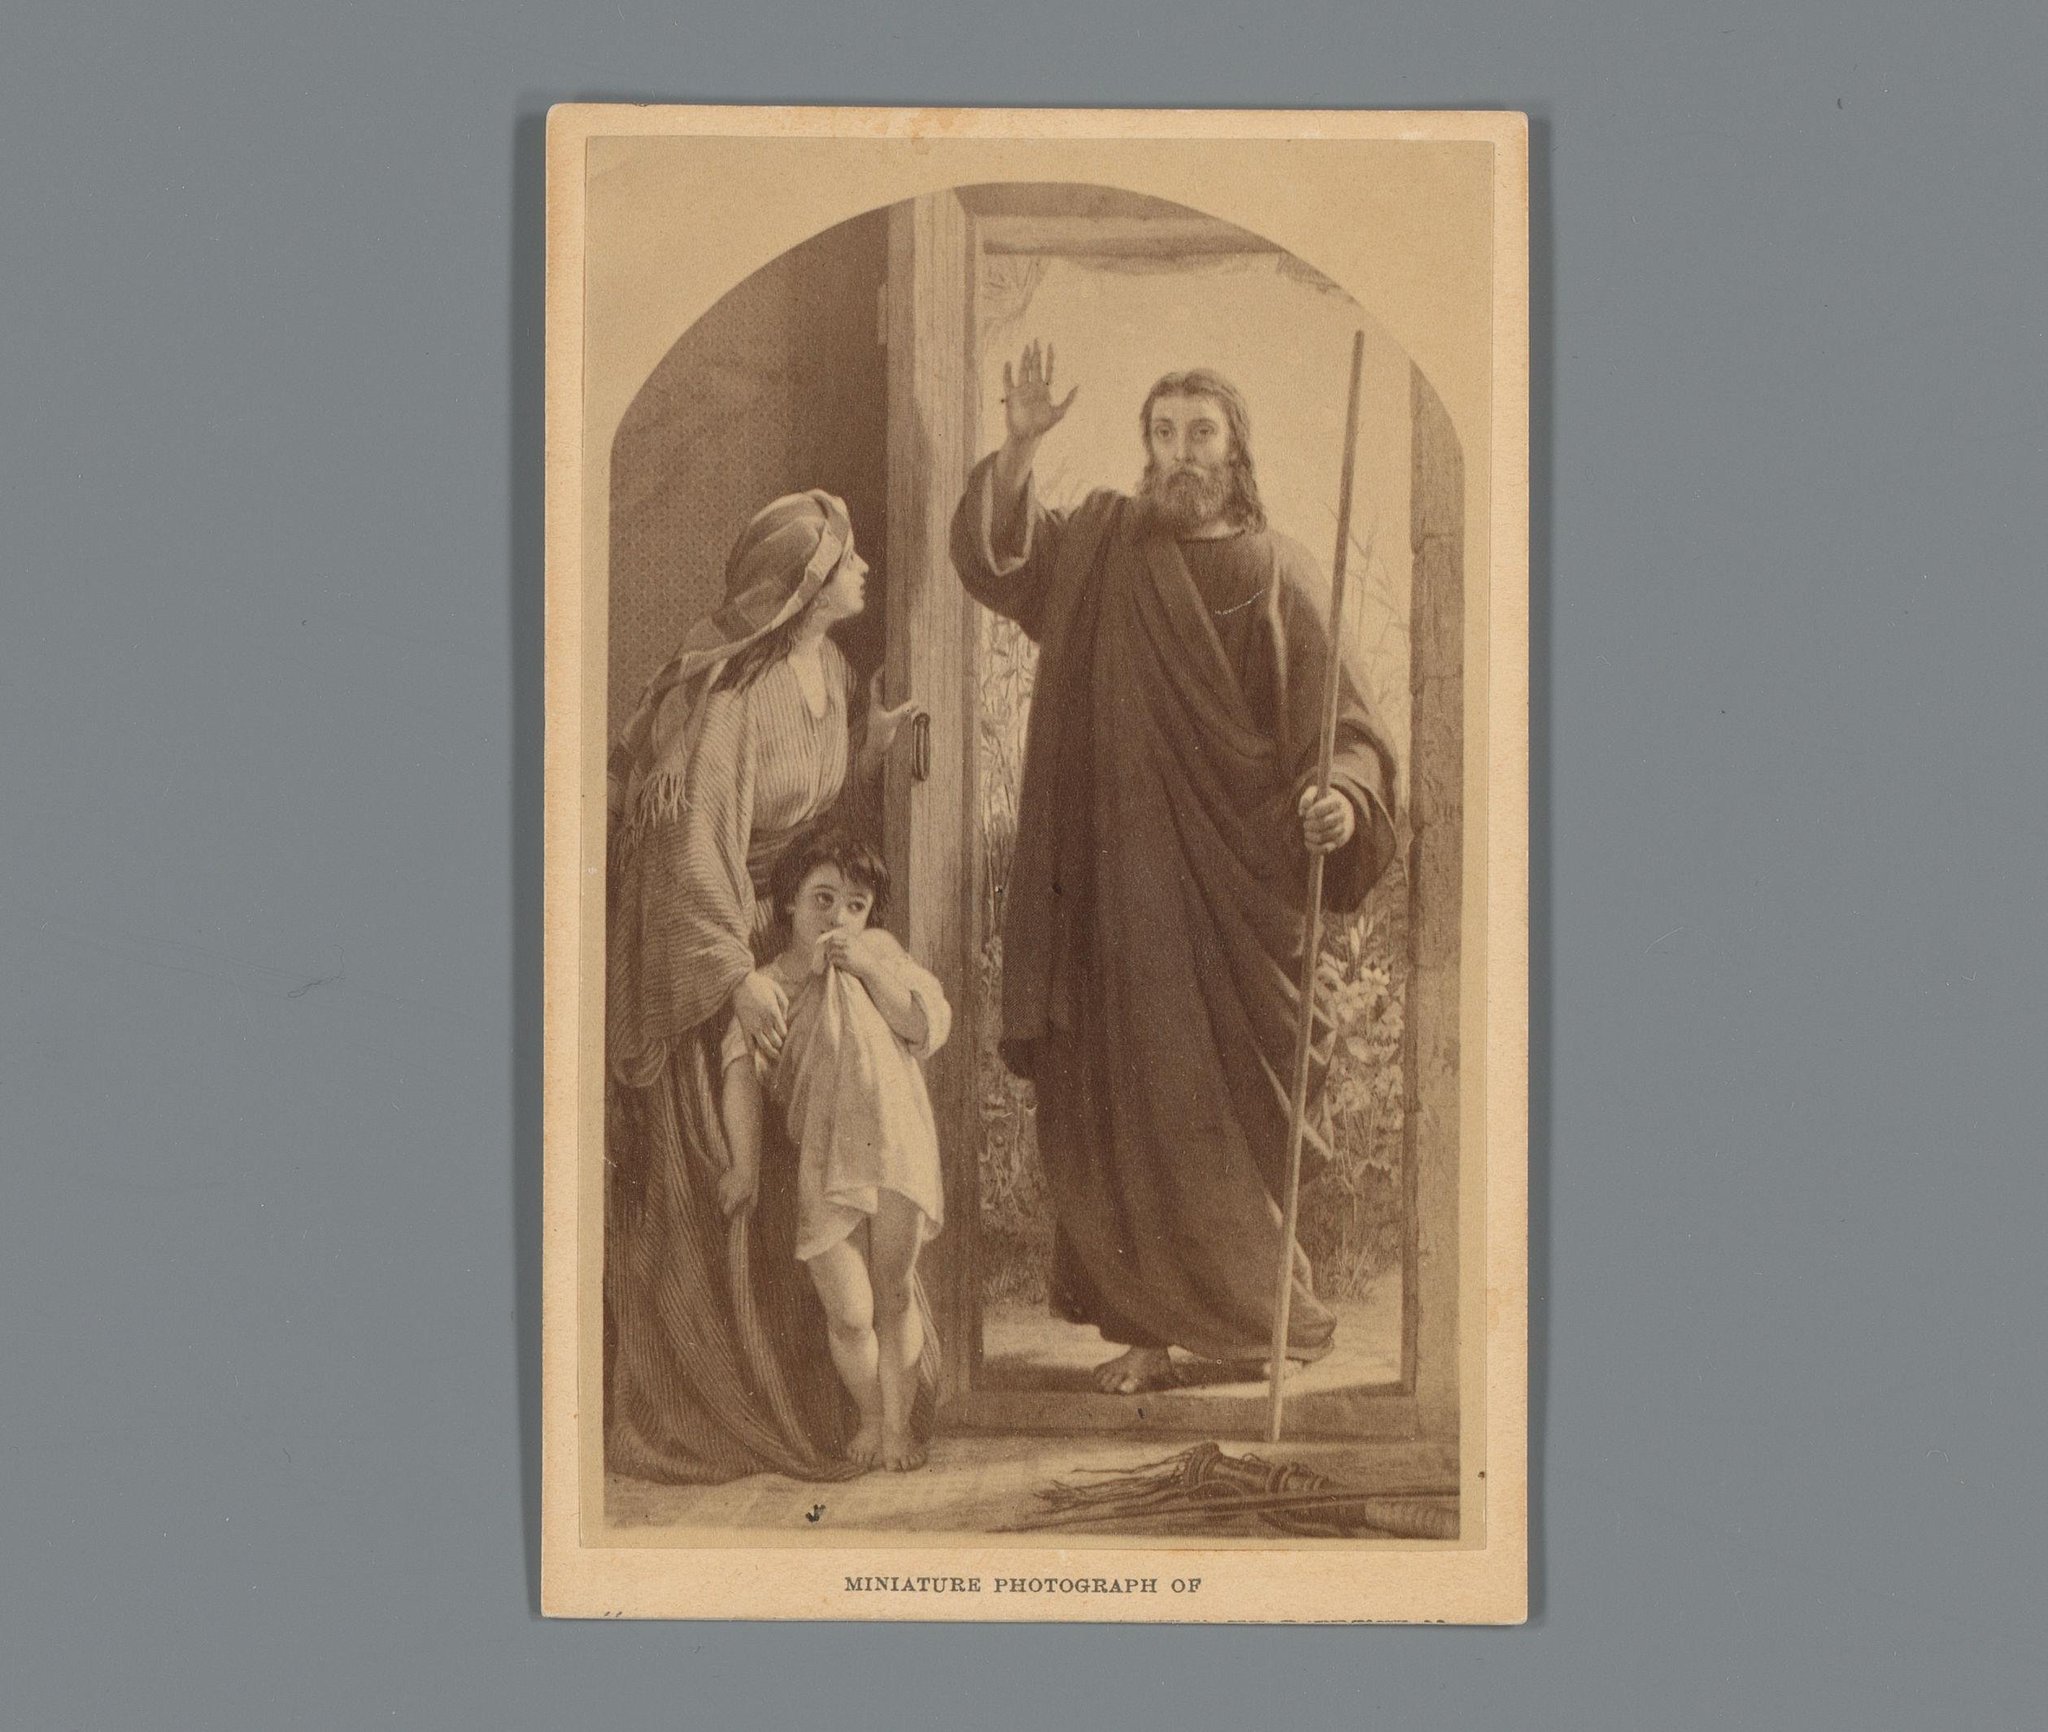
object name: reproduction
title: Fotoreproductie van een prent van Christus uitgegeven door Arthur's Illustrated Home Magazine als bijlage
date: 1850-1915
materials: cardboard, photographic support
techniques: albumen print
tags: weekly, monthly, magazine, etc., advertising, christ explaining his doctrine to women and children, christ as adult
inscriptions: inscription: ‘A Steel Engraving, Size 22x32 inches/ (...)/ ARTHUR'S/ Illustrated Home Magazine/ (...)’